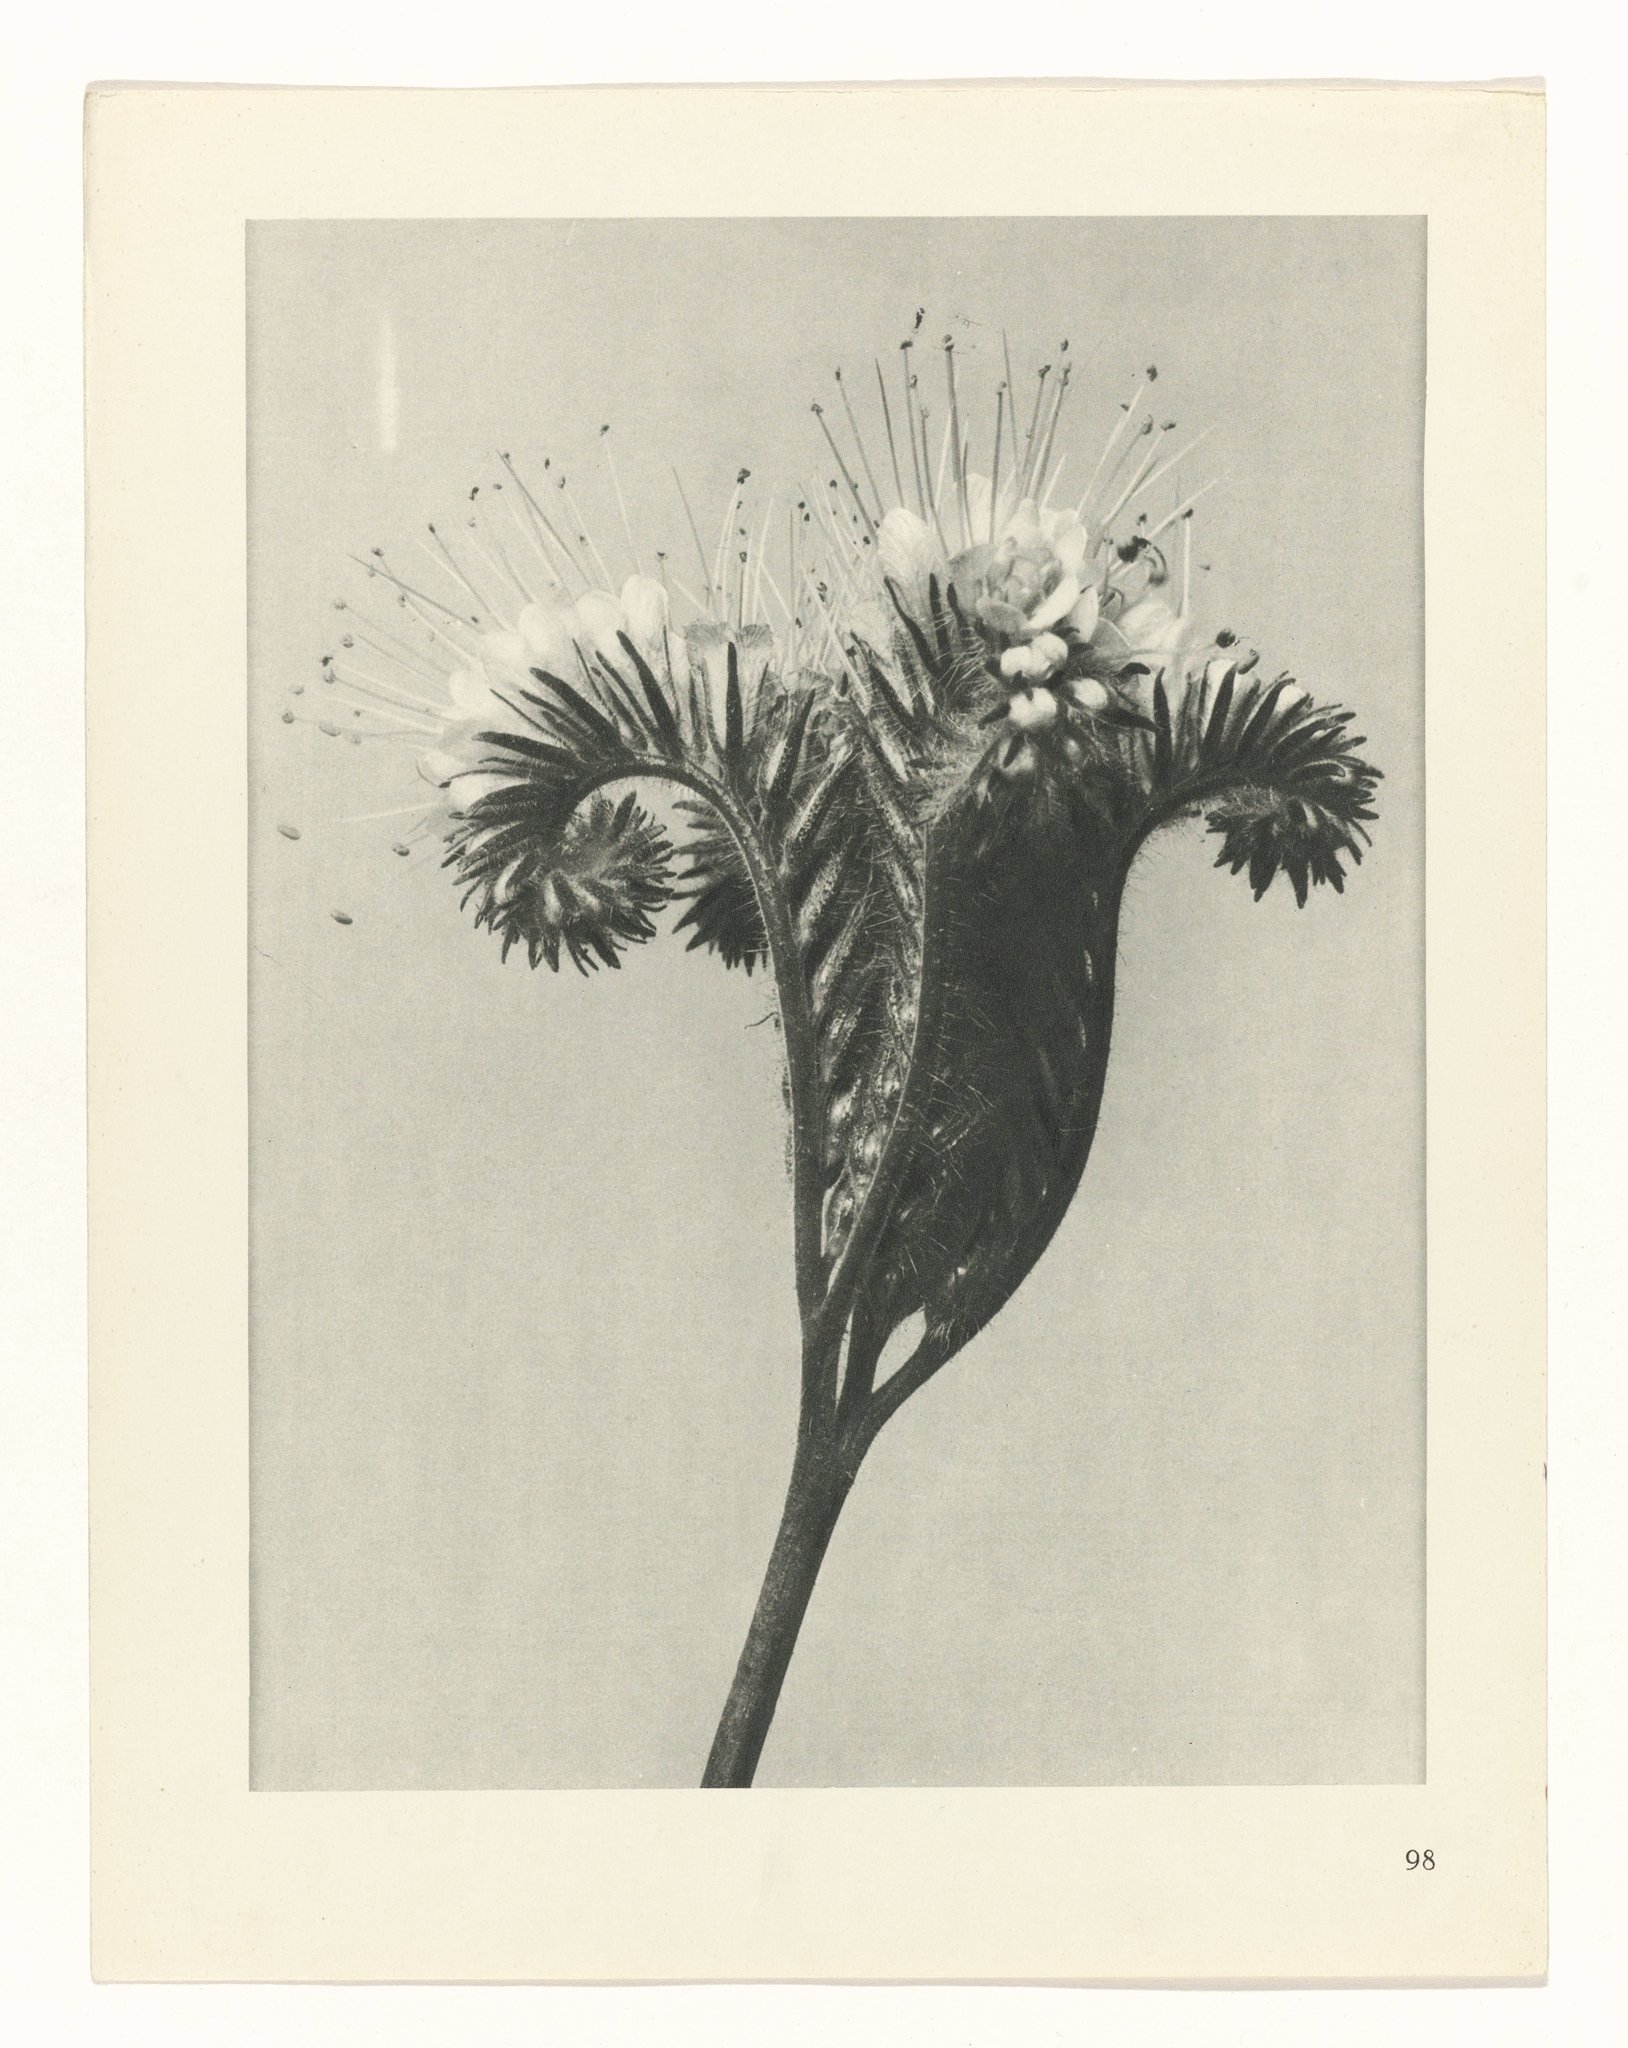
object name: photograph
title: Urformen der Kunst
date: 1928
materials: ink, paper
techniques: rotogravure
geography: berlin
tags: plants (in general)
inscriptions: number: ‘98’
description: facher Vergrößerung. Afkomstig uit losbladige uitgave.